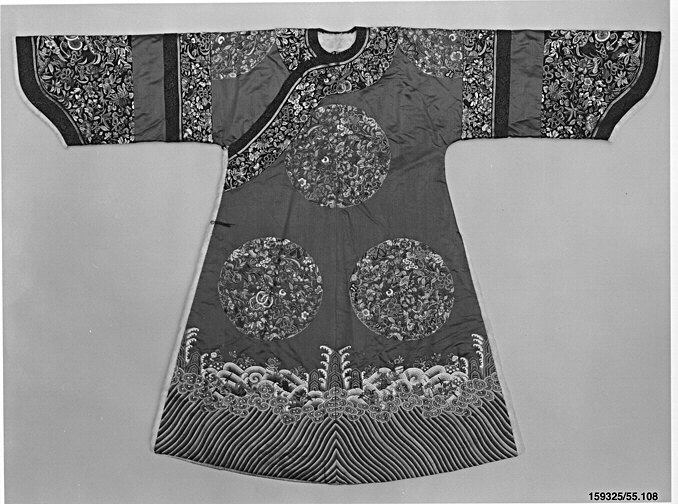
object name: woman's eight medallion ceremonial robe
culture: chinese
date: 1701-1900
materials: metal thread, textile, silk